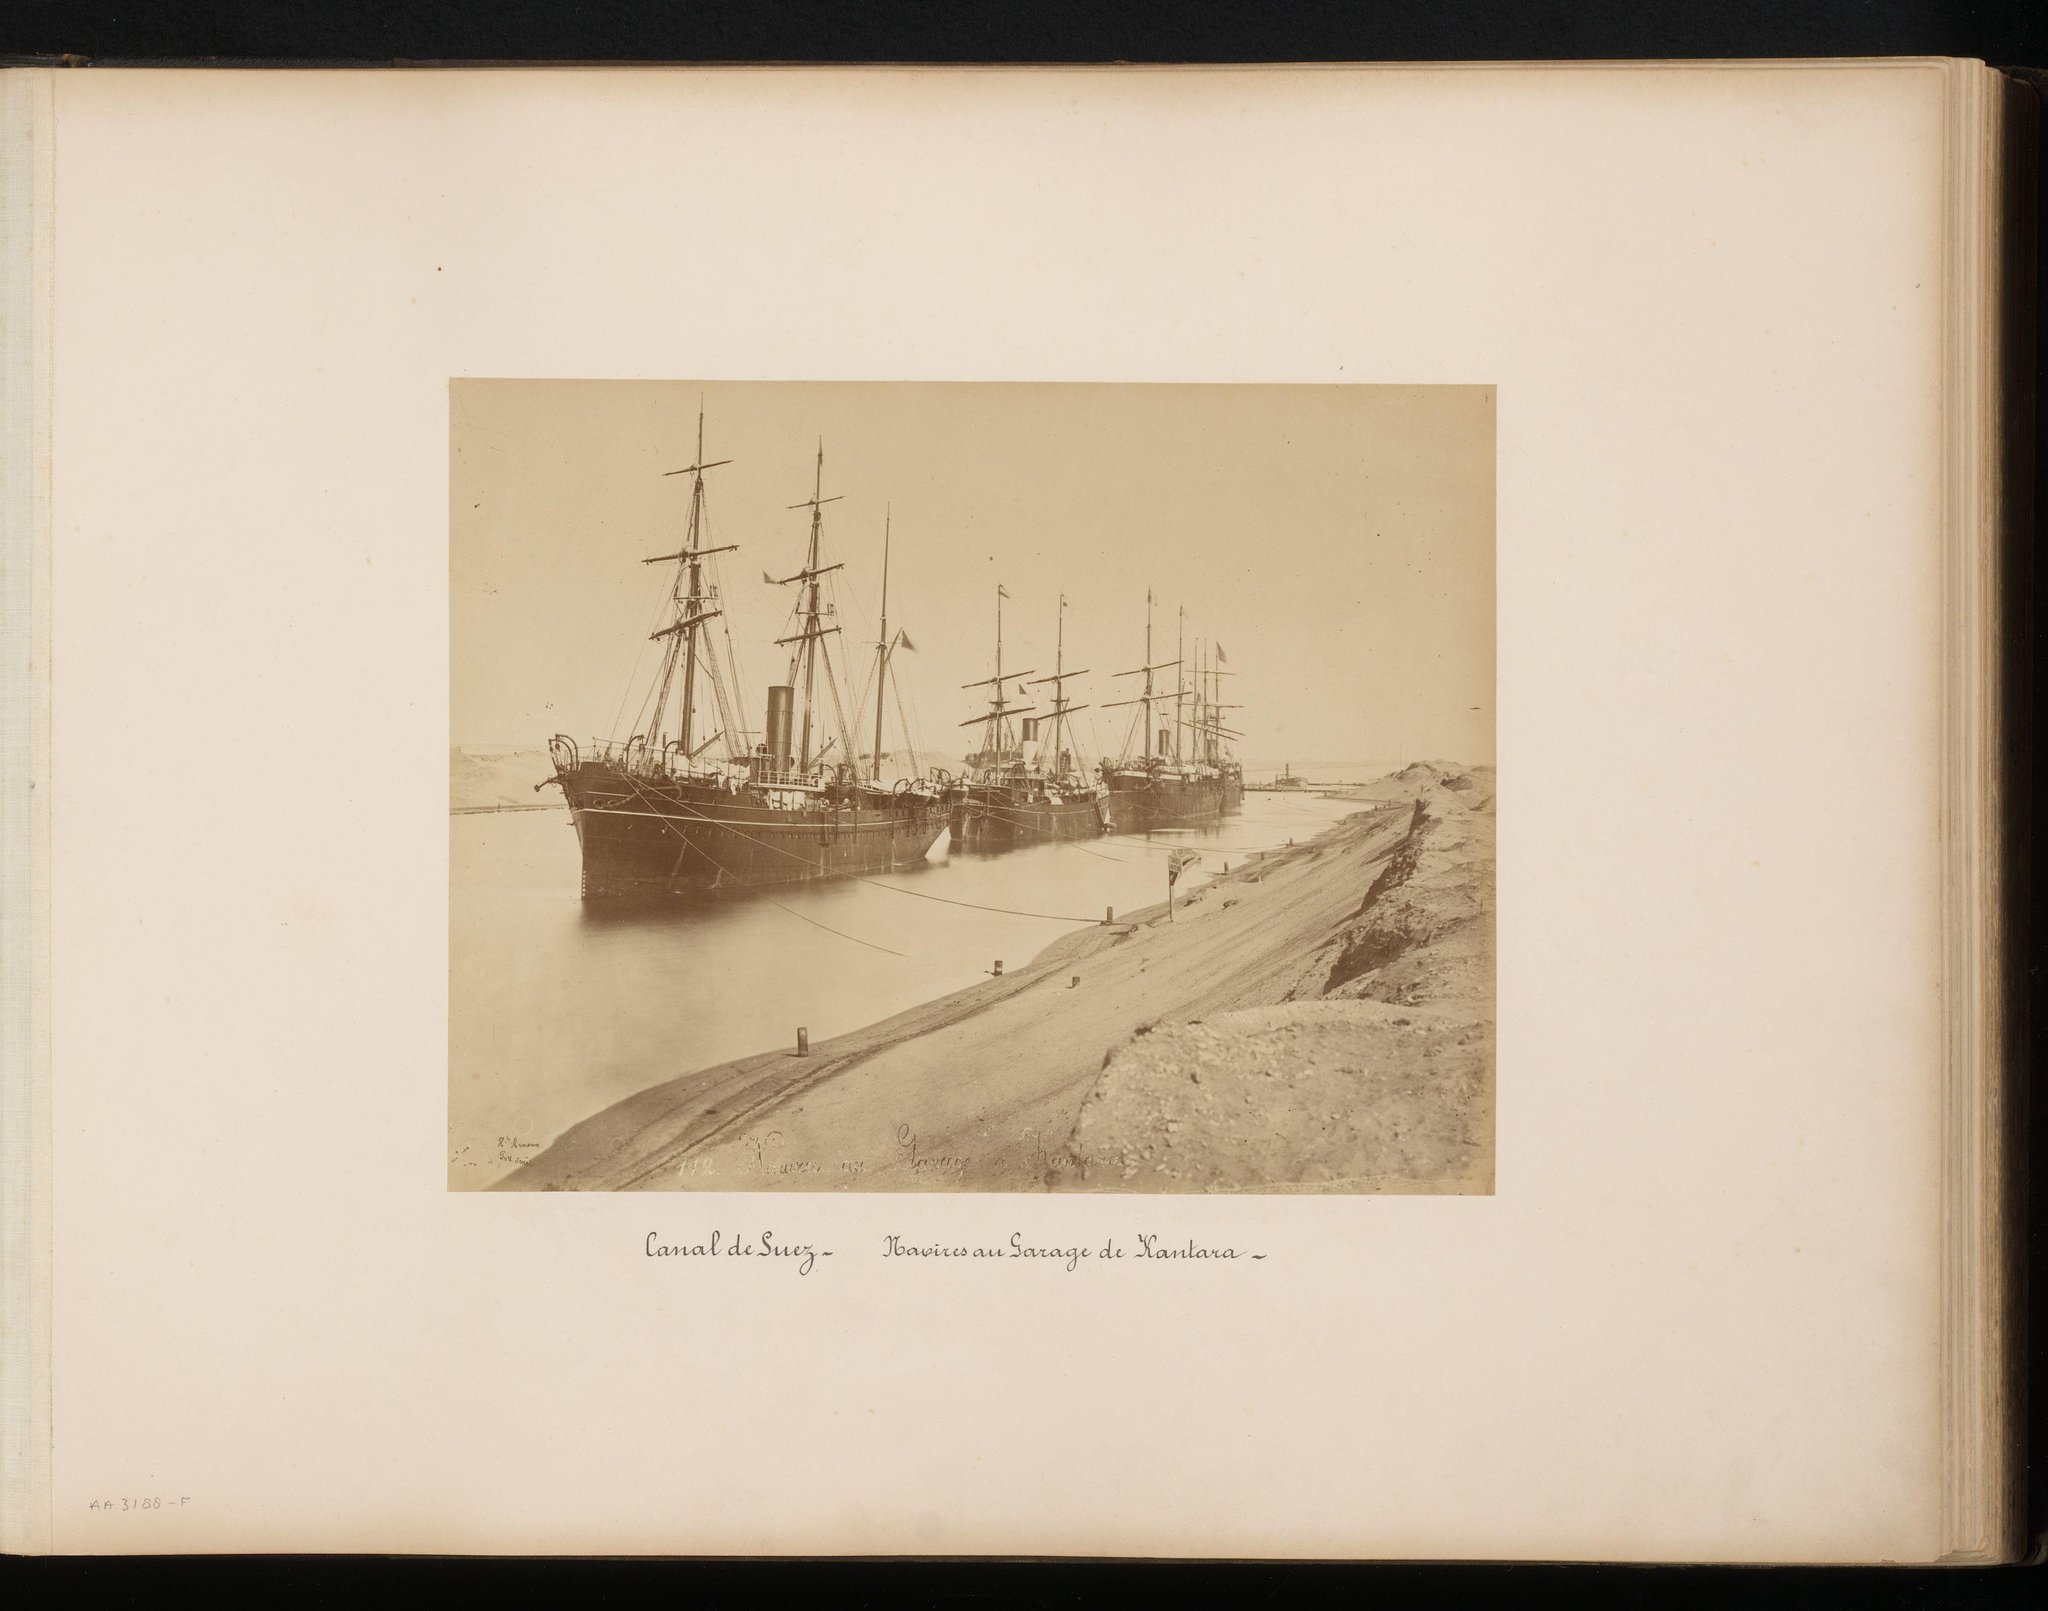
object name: photograph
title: Navires au Garage à Kantara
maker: hippolyte arnoux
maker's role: publisher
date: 1880-1883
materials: photographic support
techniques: albumen print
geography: al qantarah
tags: sailing-ship, sailing-boat, canal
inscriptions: number: ‘112’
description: Onderdeel van Reisalbum met opnames van bezienswaardigheden in Egypte, Nederlands-Indië, Singapore en Ceylon.